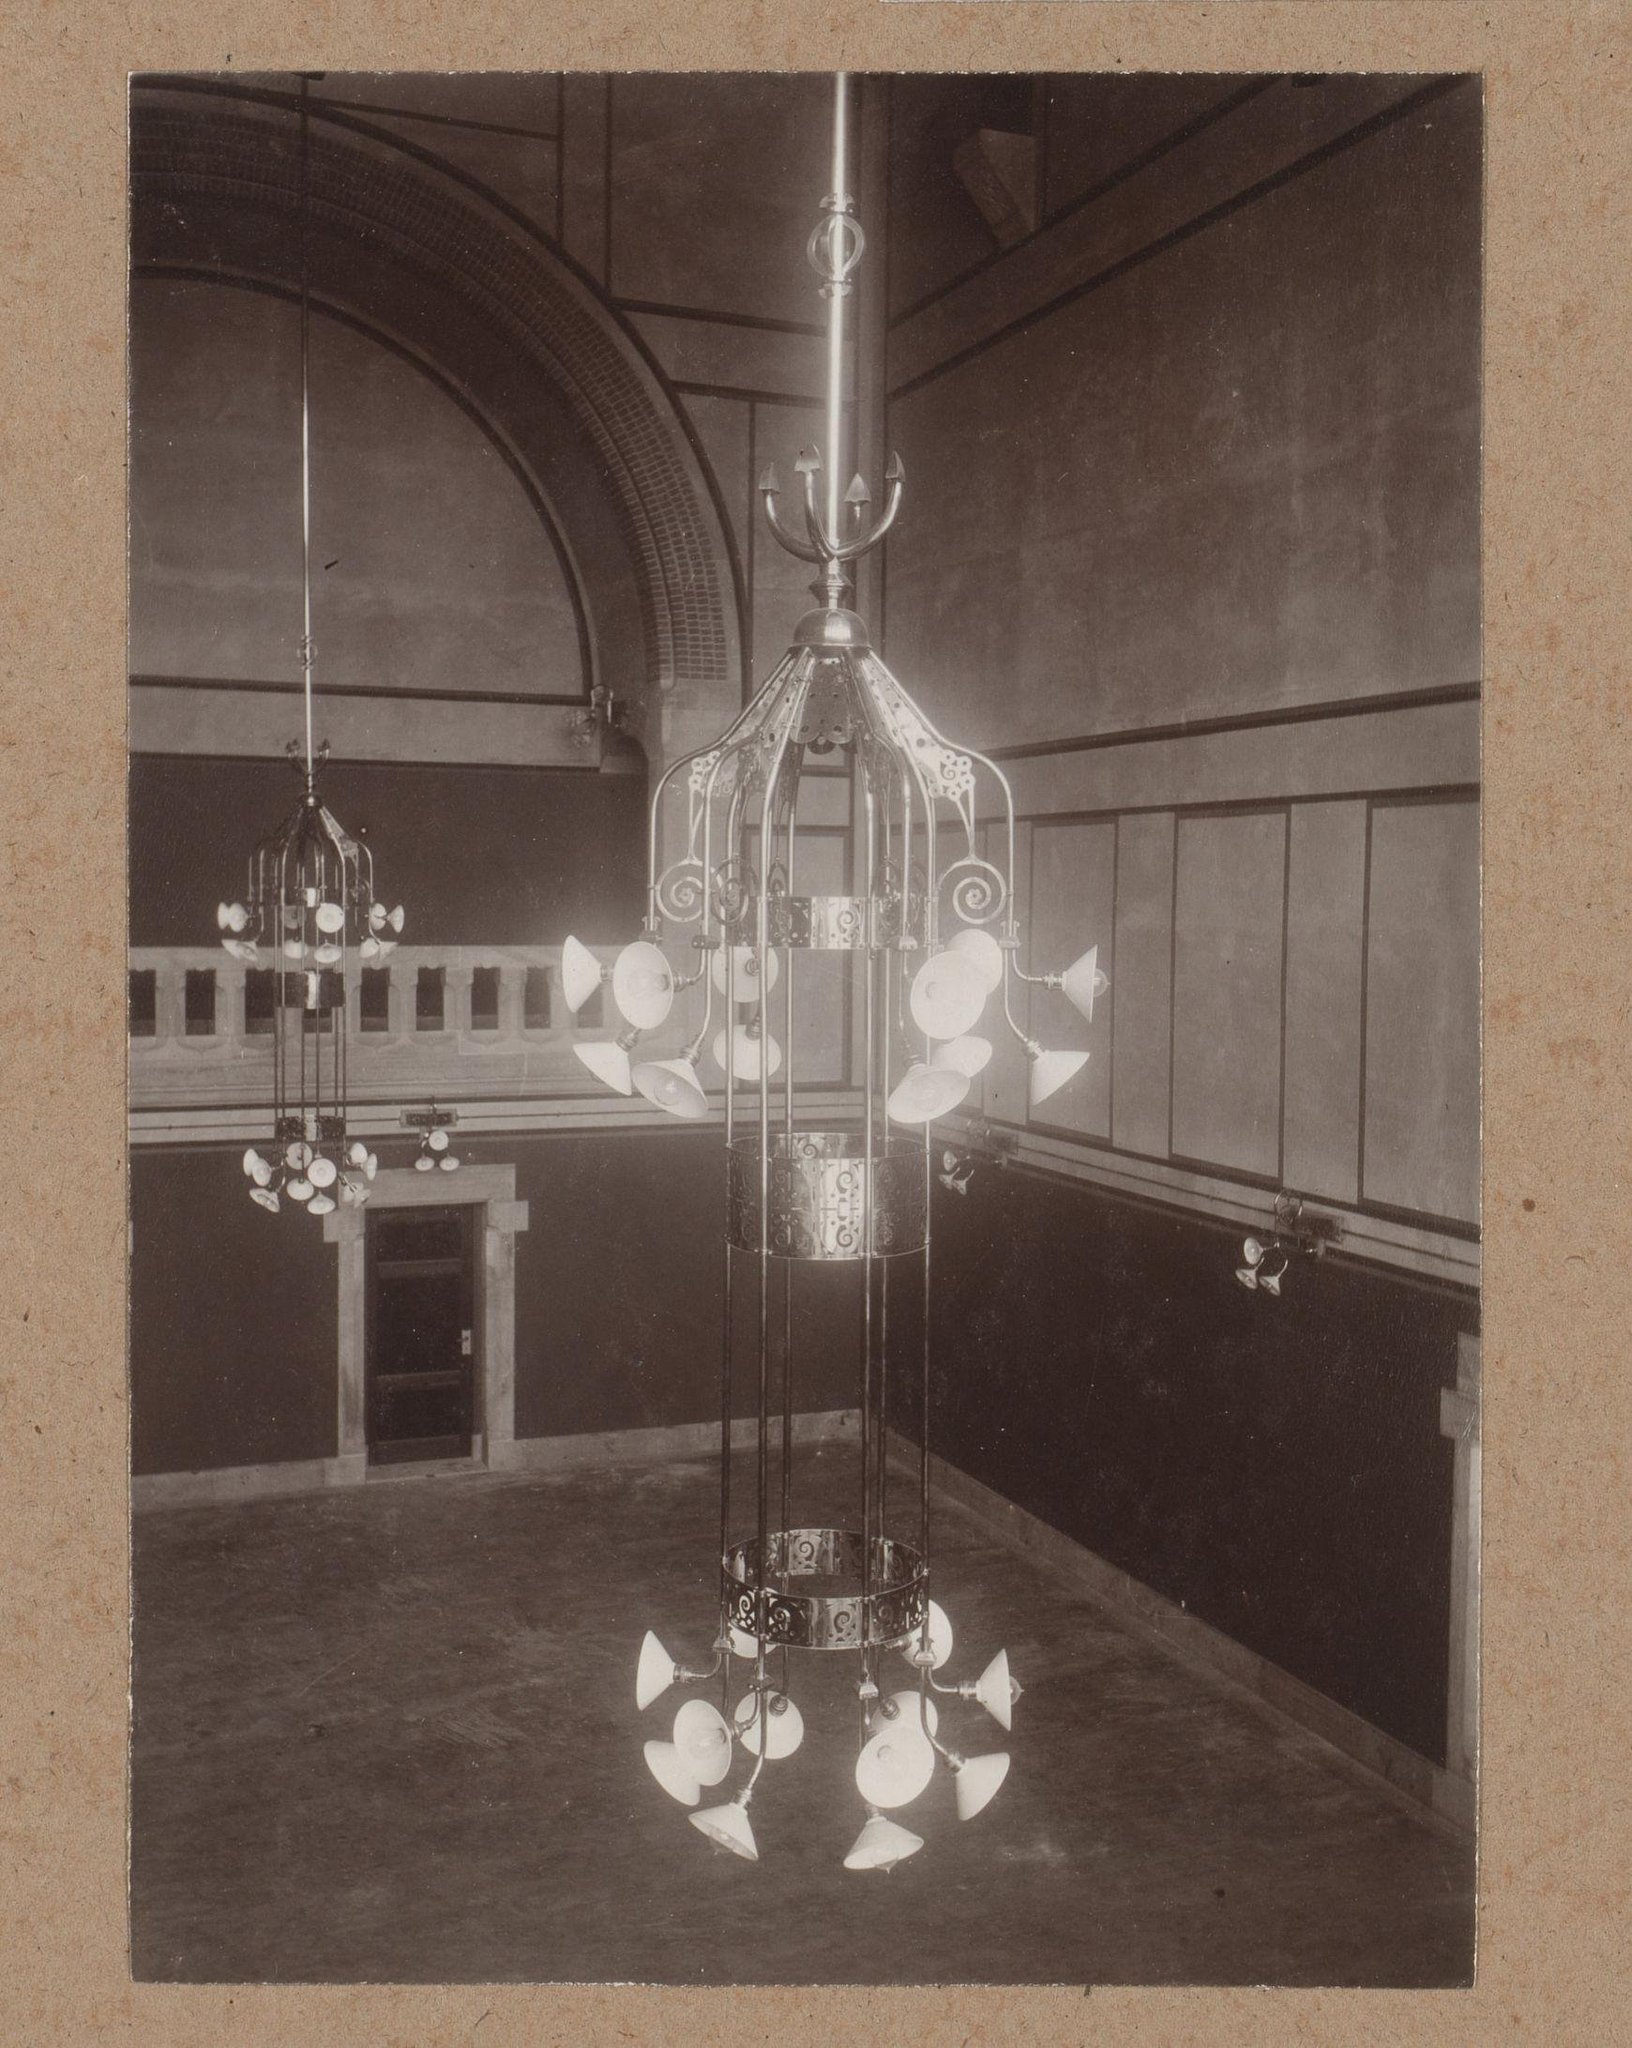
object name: photograph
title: Plafondlampen in de Beurs van Berlage te Amsterdam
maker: Anonymous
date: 1903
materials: paper, cardboard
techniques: gelatin silver print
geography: amsterdam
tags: stock exchange, stock-market, electric lamp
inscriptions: stamp: ‘Rijksmuseum/ Amsterdam’